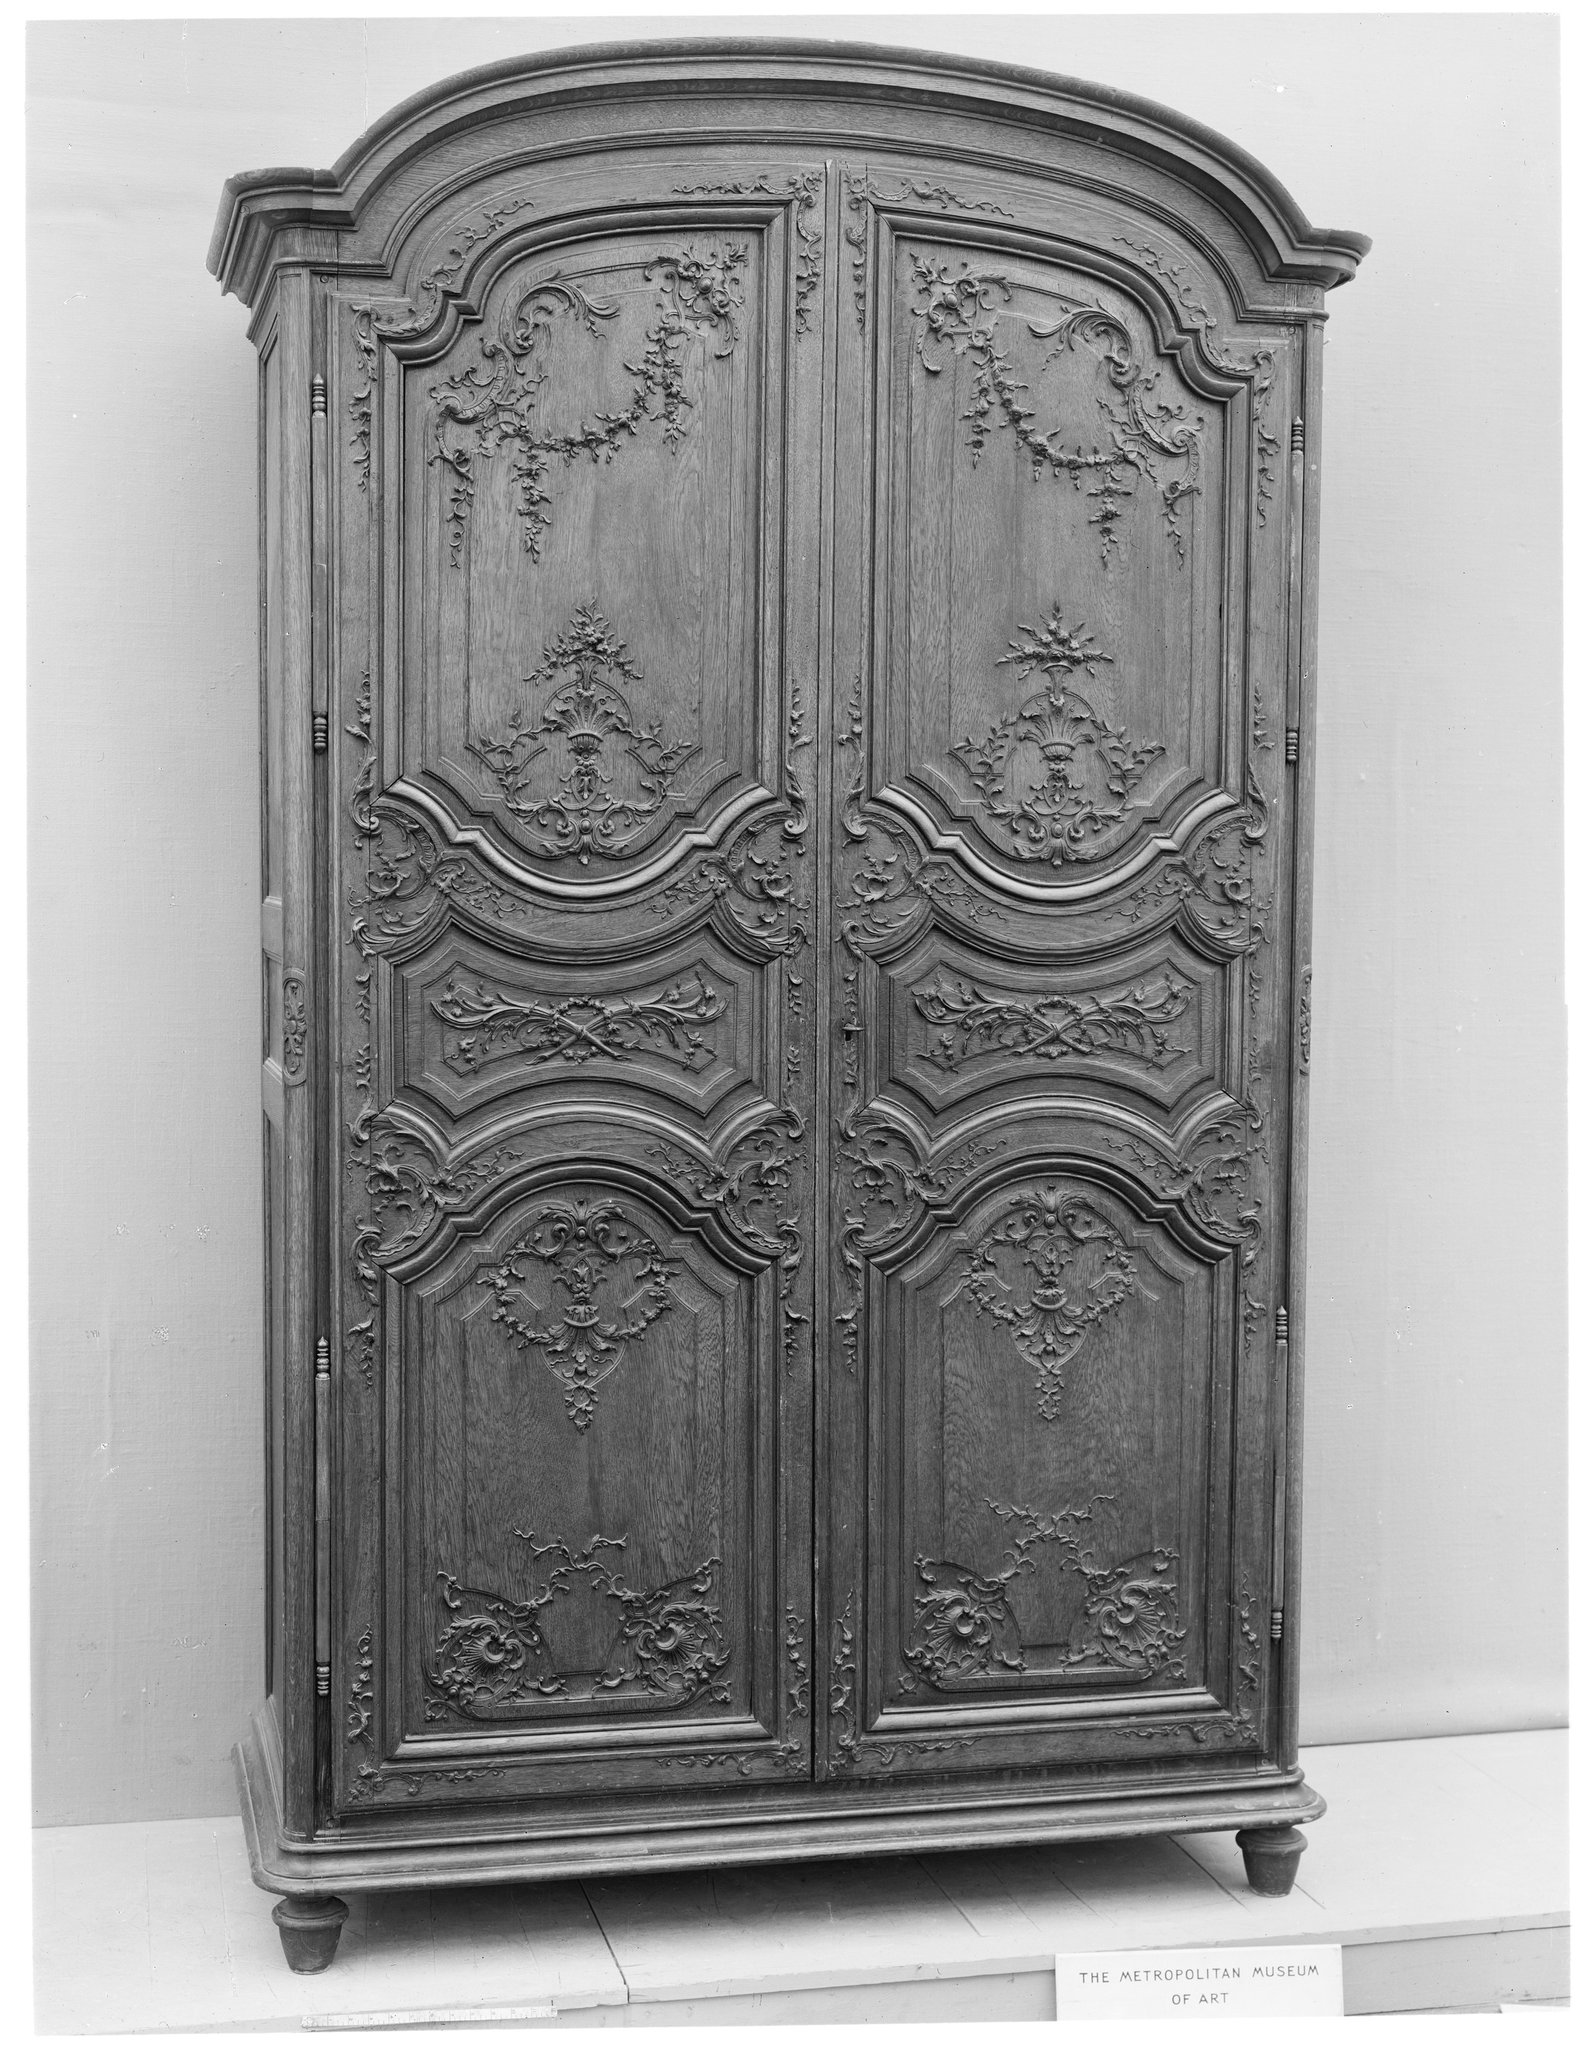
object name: armoire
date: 1701-1750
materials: wood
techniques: carving